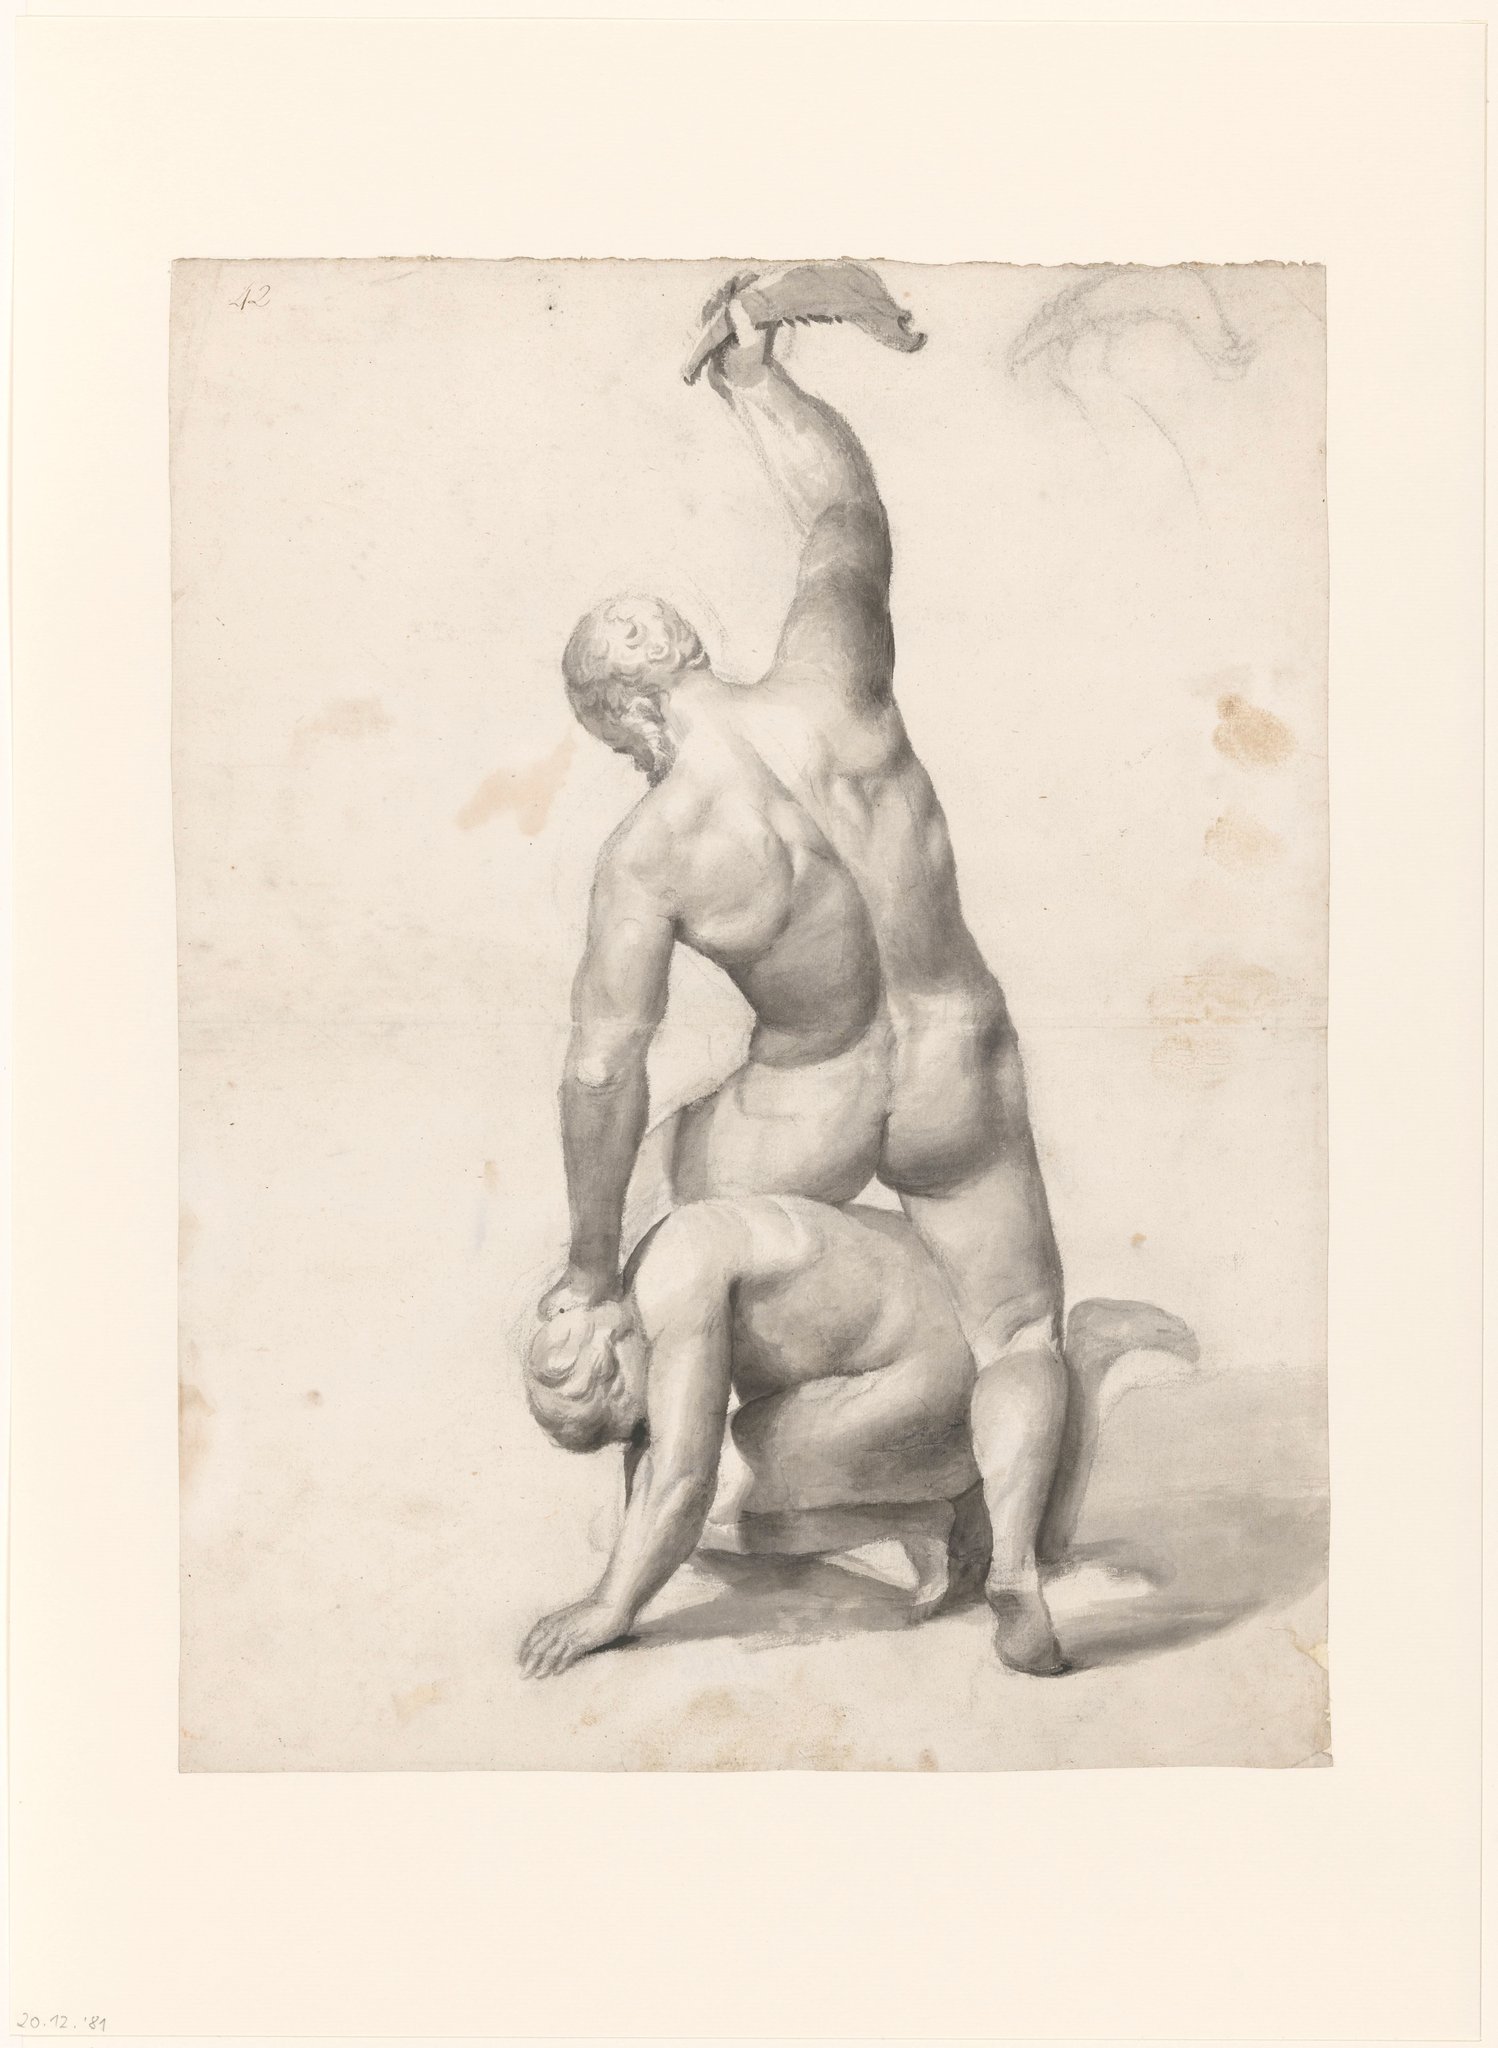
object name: drawing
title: Beeld van Simson en de Filistijnen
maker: moses ter borch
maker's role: draughtsman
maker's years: 1645-1667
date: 1657-1658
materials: chalk, ink, paper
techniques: brush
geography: zwolle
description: Het afgietsel dat Moses heeft getekend was gebaseerd op een compositie van Michelangelo, vaak gekopieerd in de Renaissance door Giambologna en de groep mensen rondom hem en door Barokke beeldhouwers als de Duitser Leonhard Kern. Een schets van het onderste gedeelte van dezelfde beeldengroep is te zien achterop een van Moses' portretten op blauw papier, M 57.